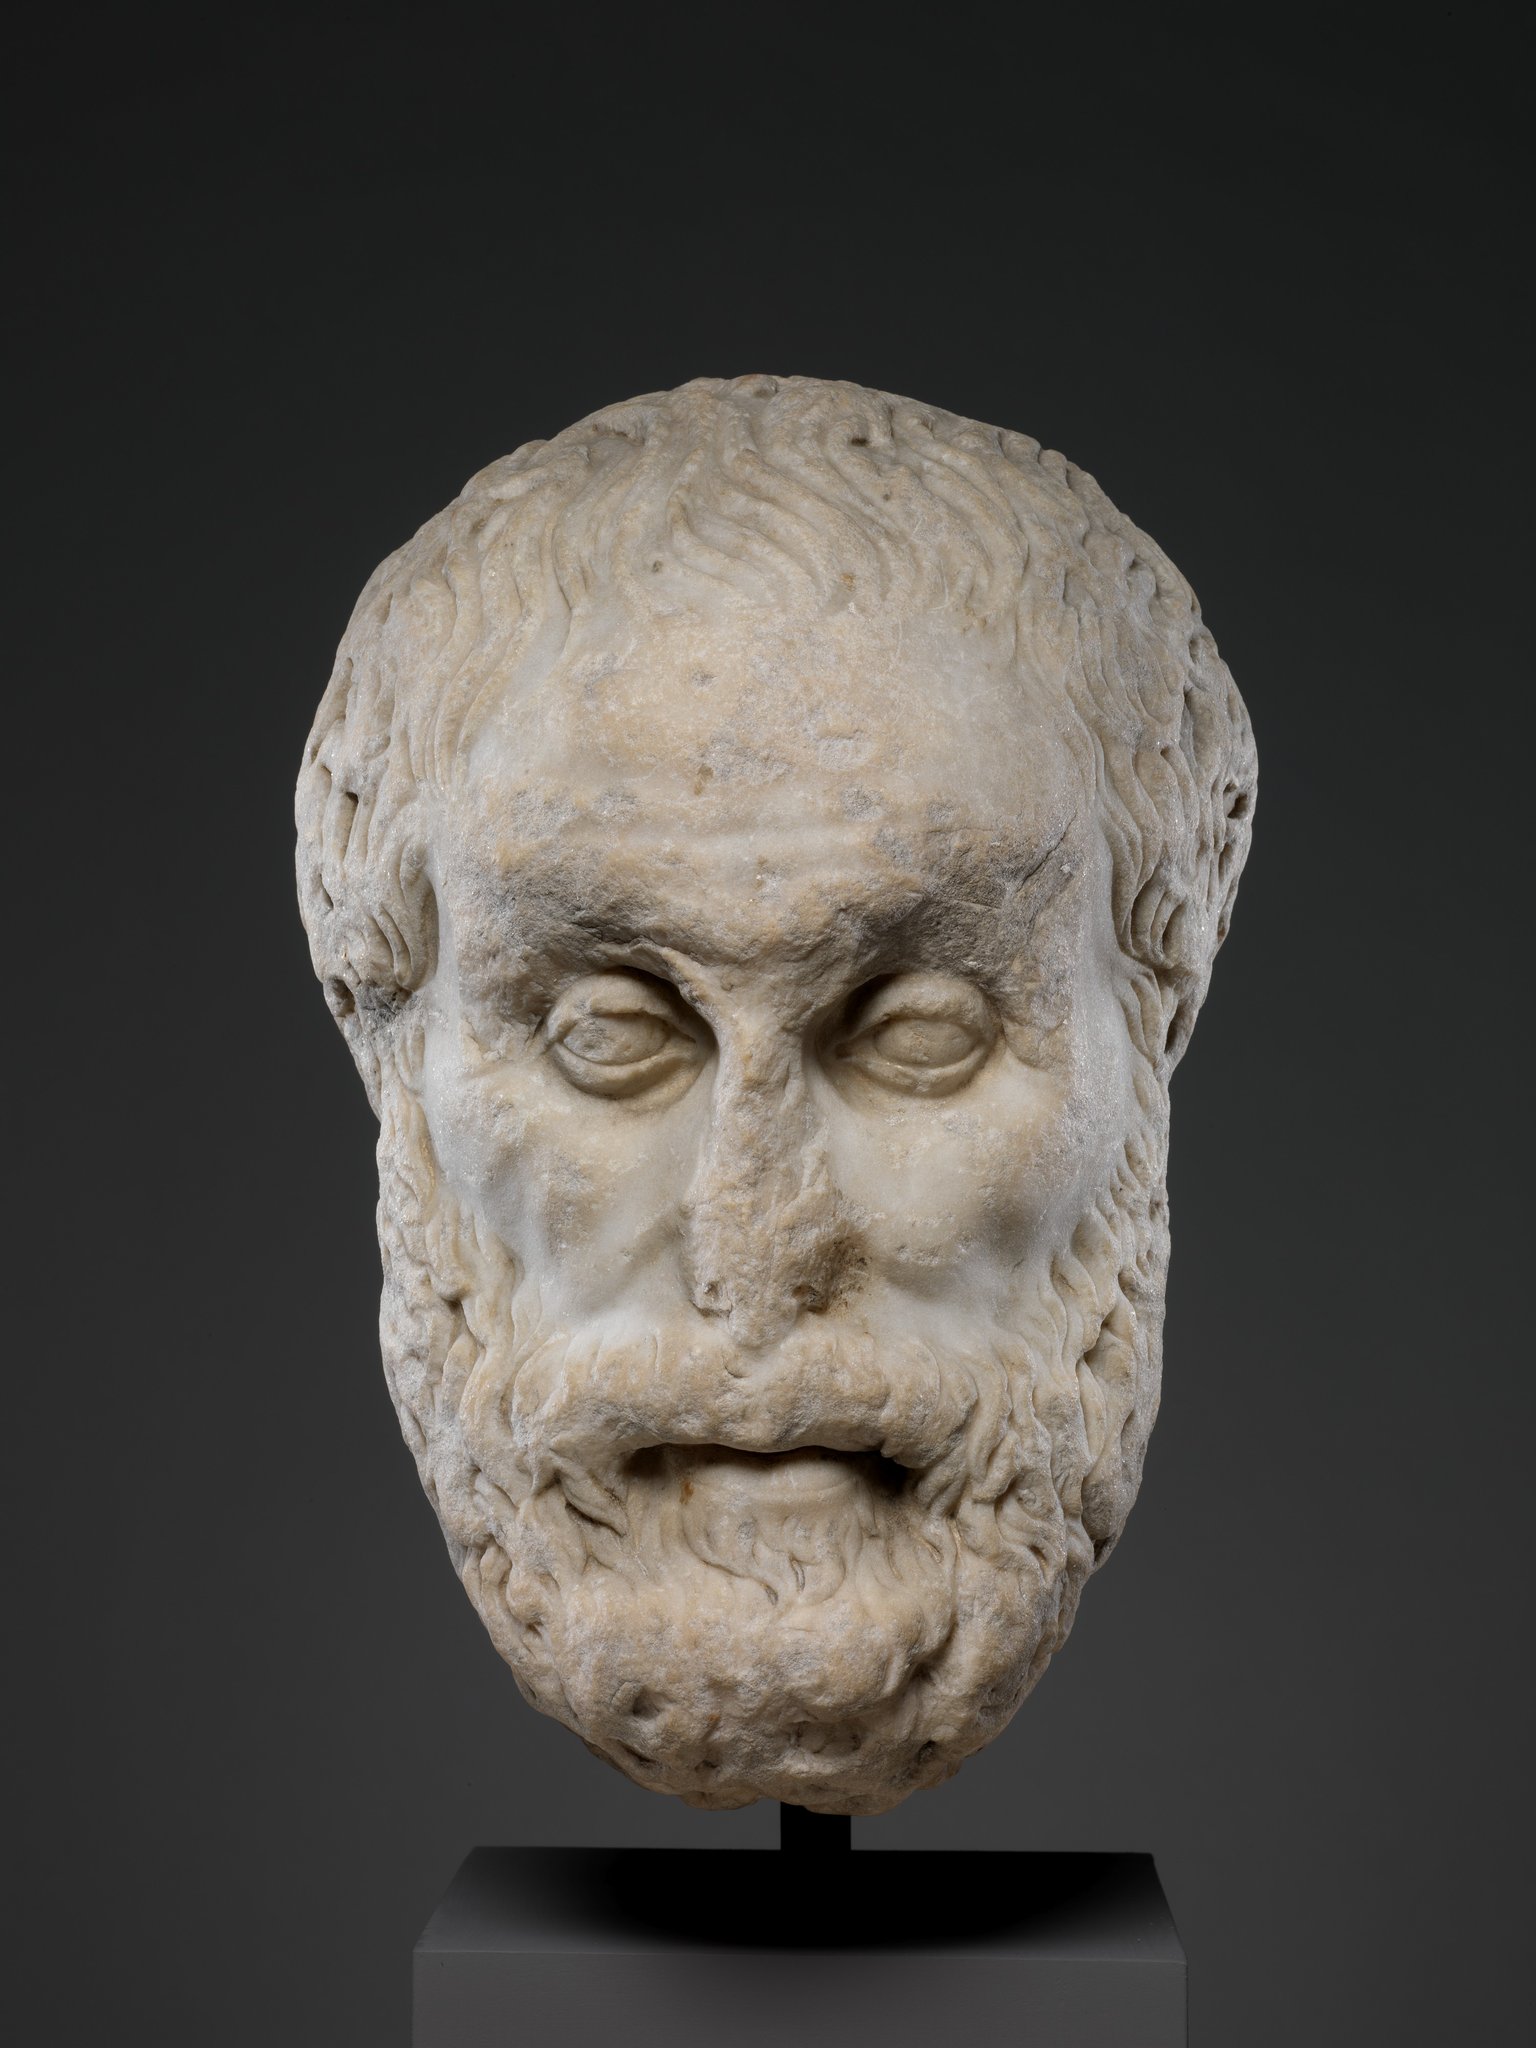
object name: head of a greek philosopher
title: Marble head of a philosopher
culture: roman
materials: marble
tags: heads,men